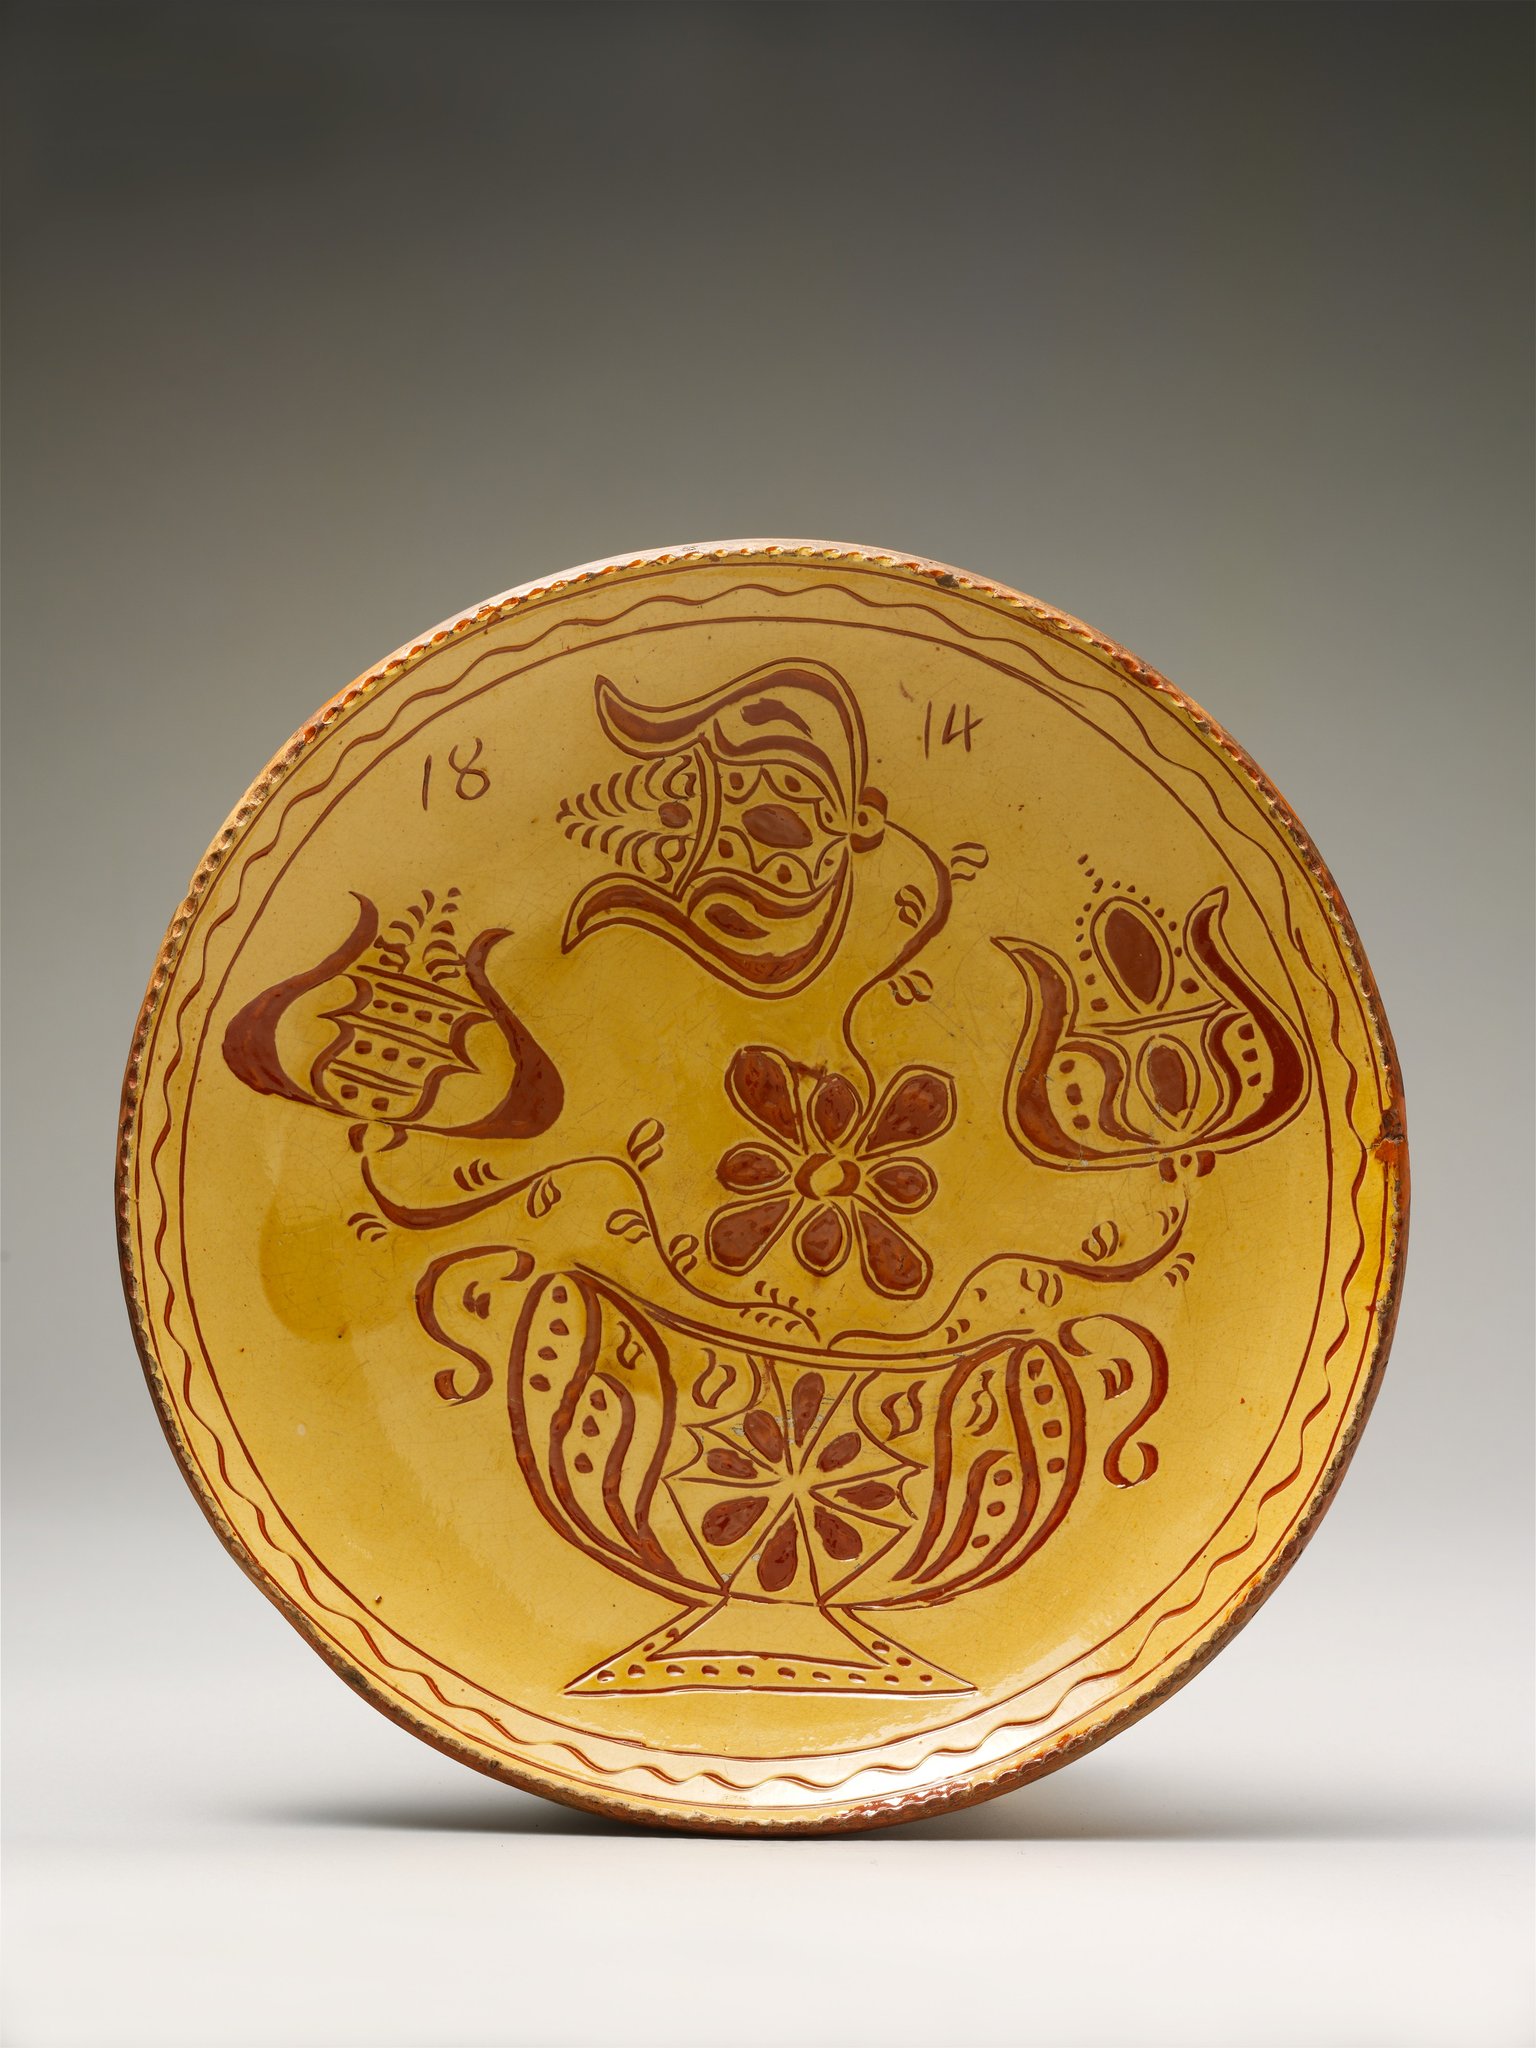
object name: plate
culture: american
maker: heinrich stofflet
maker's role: artist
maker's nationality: american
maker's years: 1812-1830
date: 1814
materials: earthenware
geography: united states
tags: flowers